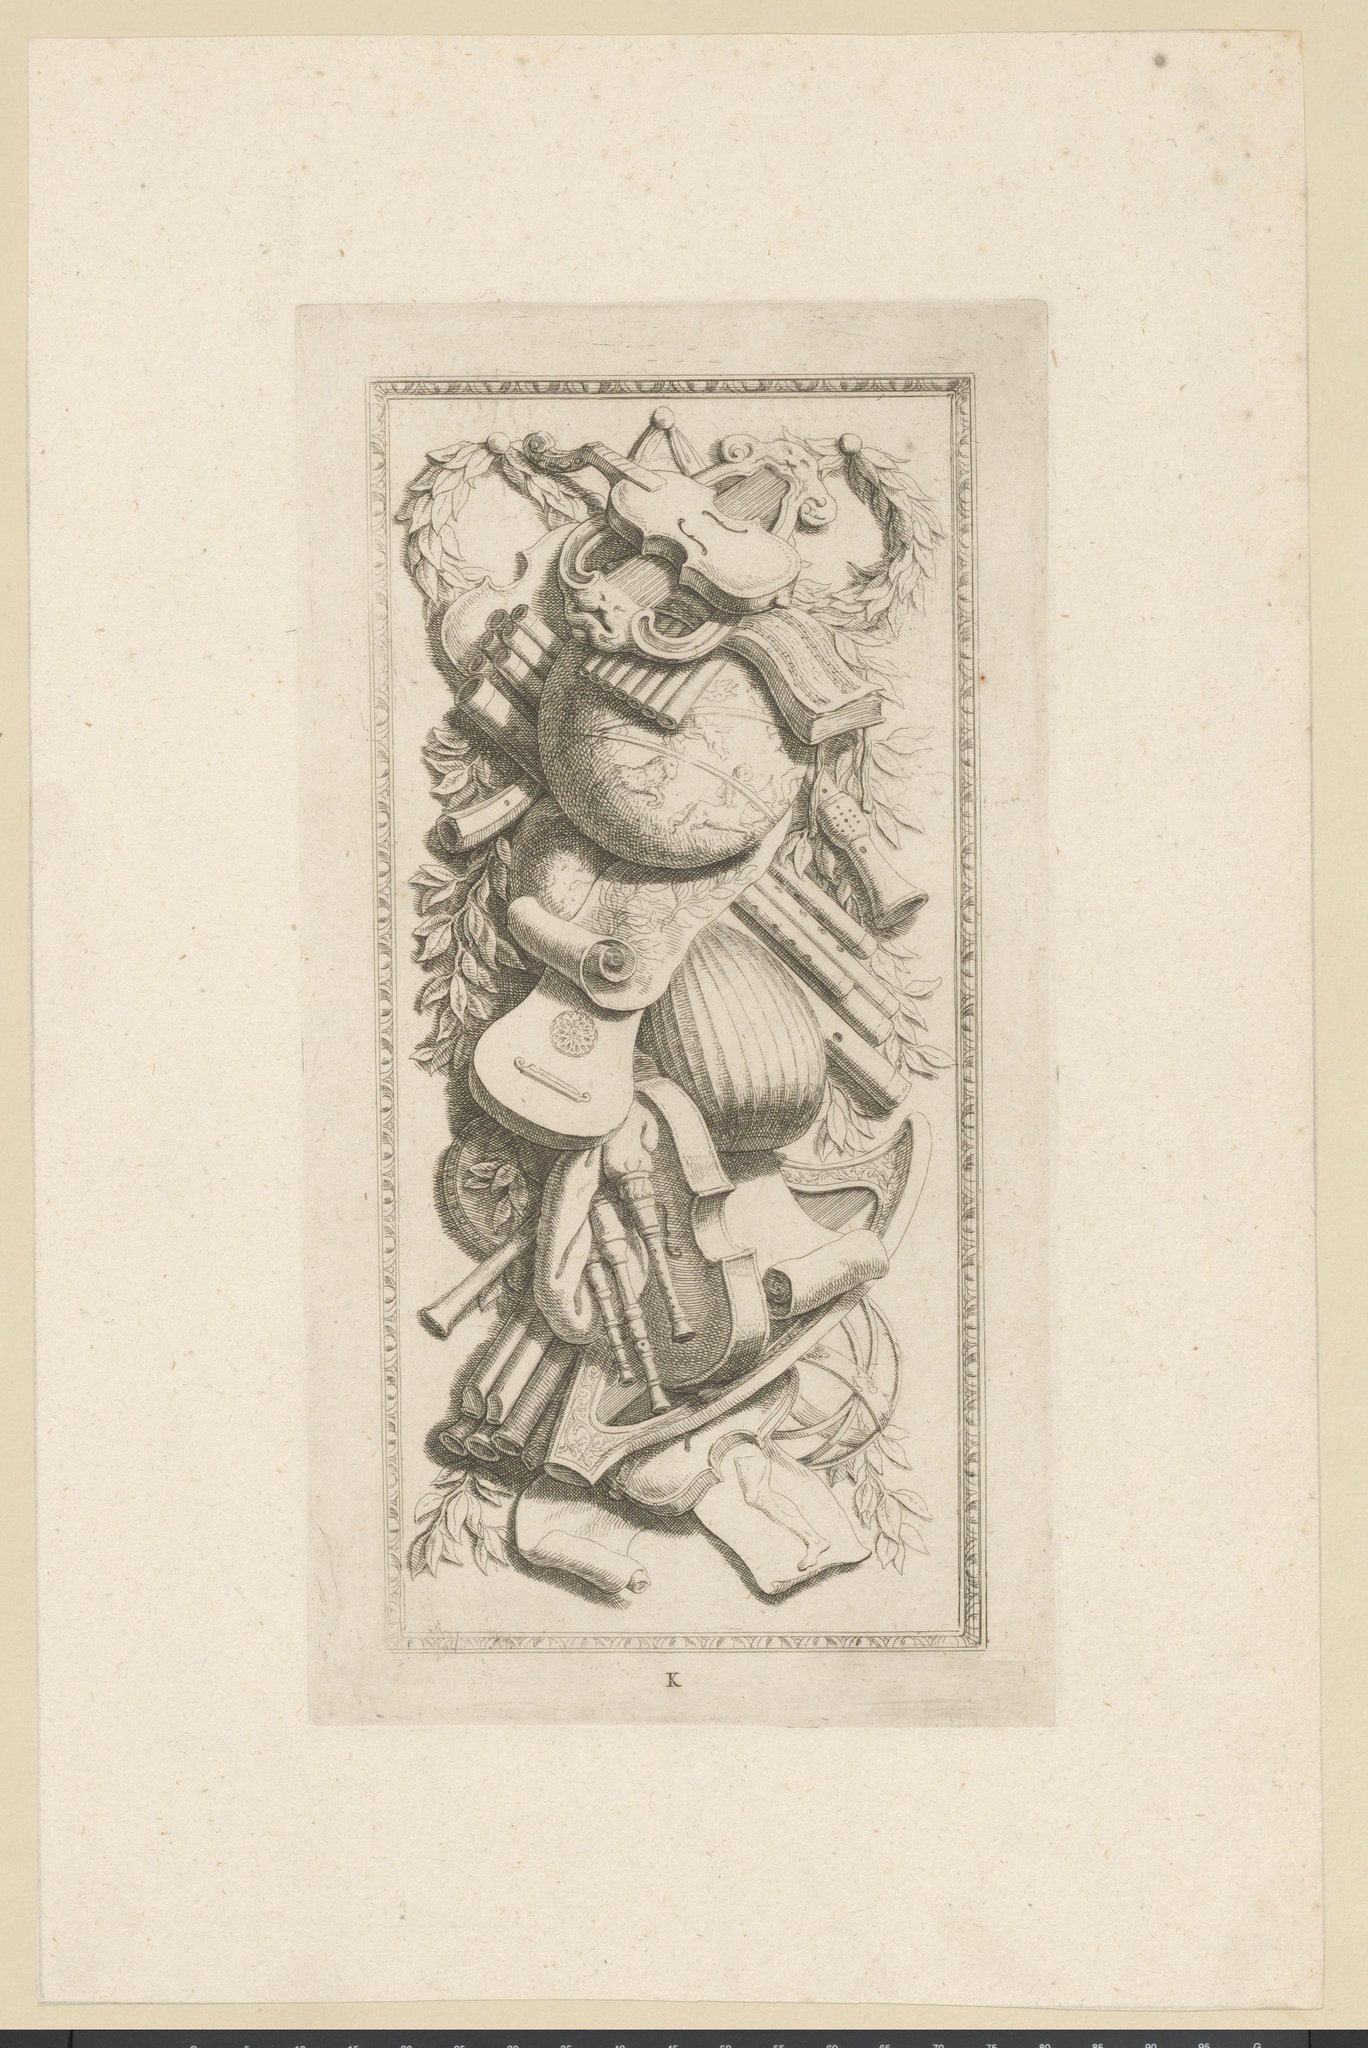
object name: print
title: Reliëf met muziekinstrumenten voor op piëdestal in de westelijke galerij van het Stadhuis op de Dam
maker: hubert quellinus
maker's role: print maker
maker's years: 1619-1687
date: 1655-1665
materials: paper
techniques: engraving, etching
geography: amsterdam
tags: musical instruments; group of musical instruments, townhall, ornament ~ festoon, garland, attributes of apollo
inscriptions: collector's mark: ‘16,35’ Lugt 1641b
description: Prent gebruikt in: Prima pars. Praecipuarum effigierum ac ornamentorum, amplissimae Curiae Amstelrodamensis (…) / Het eerste deel. Van de voornaemste Statuen ende Ciraten, vant konstijck Stadhuys van Amstelredam, tmeeste in marmer gemaeckt, door Artus Quellinus, Beelthouwer der voorseyde Stadt / La Premier Partie. De plusieurs Figures et ornements, de la Maison de Ville d'Amsterdam (…). Amsterdam: Artus Quellinus (I), 1655. Zie RP-P-AO-22-1-1 voor bijhorende titelpagina. Zie RP-P-AO-22-1-2 voor bijhorend register. Zie RP-P-AO-22-1A, RP-P-AO-22-1B, RP-P-AO-22-1C, RP-P-AO-22-1D-1, RP-P-AO-22-1D-2, RP-P-AO-22-1E, RP-P-AO-22-1F, RP-P-AO-22-1G, RP-P-AO-22-1H, RP-P-AO-22-1I, RP-P-AO-22-1K-1, RP-P-AO-22-1K-2, RP-P-AO-22-1K-3, RP-P-AO-22-1K-4, RP-P-AO-22-1L-1, RP-P-AO-22-1L-2, RP-P-AO-22-1M-1, RP-P-AO-22-1M-2, RP-P-AO-22-1N-1, RP-P-AO-22-1N-2, RP-P-AO-22-1N-3, RP-P-AO-22-1N-4, RP-P-AO-22-1N-5, RP-P-AO-22-1O-1, RP-P-AO-22-1O-2, RP-P-AO-22-1O-3, RP-P-AO-22-1O-4, RP-P-AO-22-1P-1, RP-P-AO-22-1P-2, RP-P-AO-22-1P-3, RP-P-AO-22-1P-4, RP-P-AO-22-1Q-1, RP-P-AO-22-1Q-2, RP-P-AO-22-1Q-3, RP-P-AO-22-1Q-4, RP-P-AO-22-1R-1, RP-P-AO-22-1R-2, RP-P-AO-22-1R-3, RP-P-AO-22-1R-4, RP-P-AO-22-1R-5, RP-P-AO-22-1S-1, RP-P-AO-22-1S-2, RP-P-AO-22-1S-3, RP-P-AO-22-1S-4, RP-P-AO-22-1S-5, RP-P-AO-22-1T-1 en RP-P-AO-22-1T-2 voor andere prenten uit deze publicatie. Zelfde staat van prent ook gebruikt in: Prima pars. Praecipuarum effigierum ac ornamentorum, amplissimae Curiae Amstelrodamensis (…) / Het eerste deel. Van de voornaemste Statuen ende Ciraten, vant konstijck Stadhuys van Amstelredam, tmeeste in marmer gemaeckt, door Artus Quellinus, Beelthouwer der voorseyde Stadt / La Premier Partie. De plusieurs Figures et ornements, de la Maison de Ville d'Amsterdam (…). Amsterdam: Frederik de Wit, 1665. Latere staat van prent ook gebruikt in: Architecture peinture et sculpture de la Maison de Ville d'Amsterdam, representee en CIX. figures en taille-douce (…). Amsterdam: David Mortier, 1719. En in: Architecture peinture et sculpture de la Maison de Ville d'Amsterdam, representee en CIX. figures en taille-douce (…). Amsterdam: Gerard Valck, 1719. En in: Bouw schilder en beeldhouwkonst, van het Stadhuis te Amsteldam, vertoont in CIX figuuren (…). Amsterdam: Covens & Mortier & Covens Jr., s.a. (1774-1783).